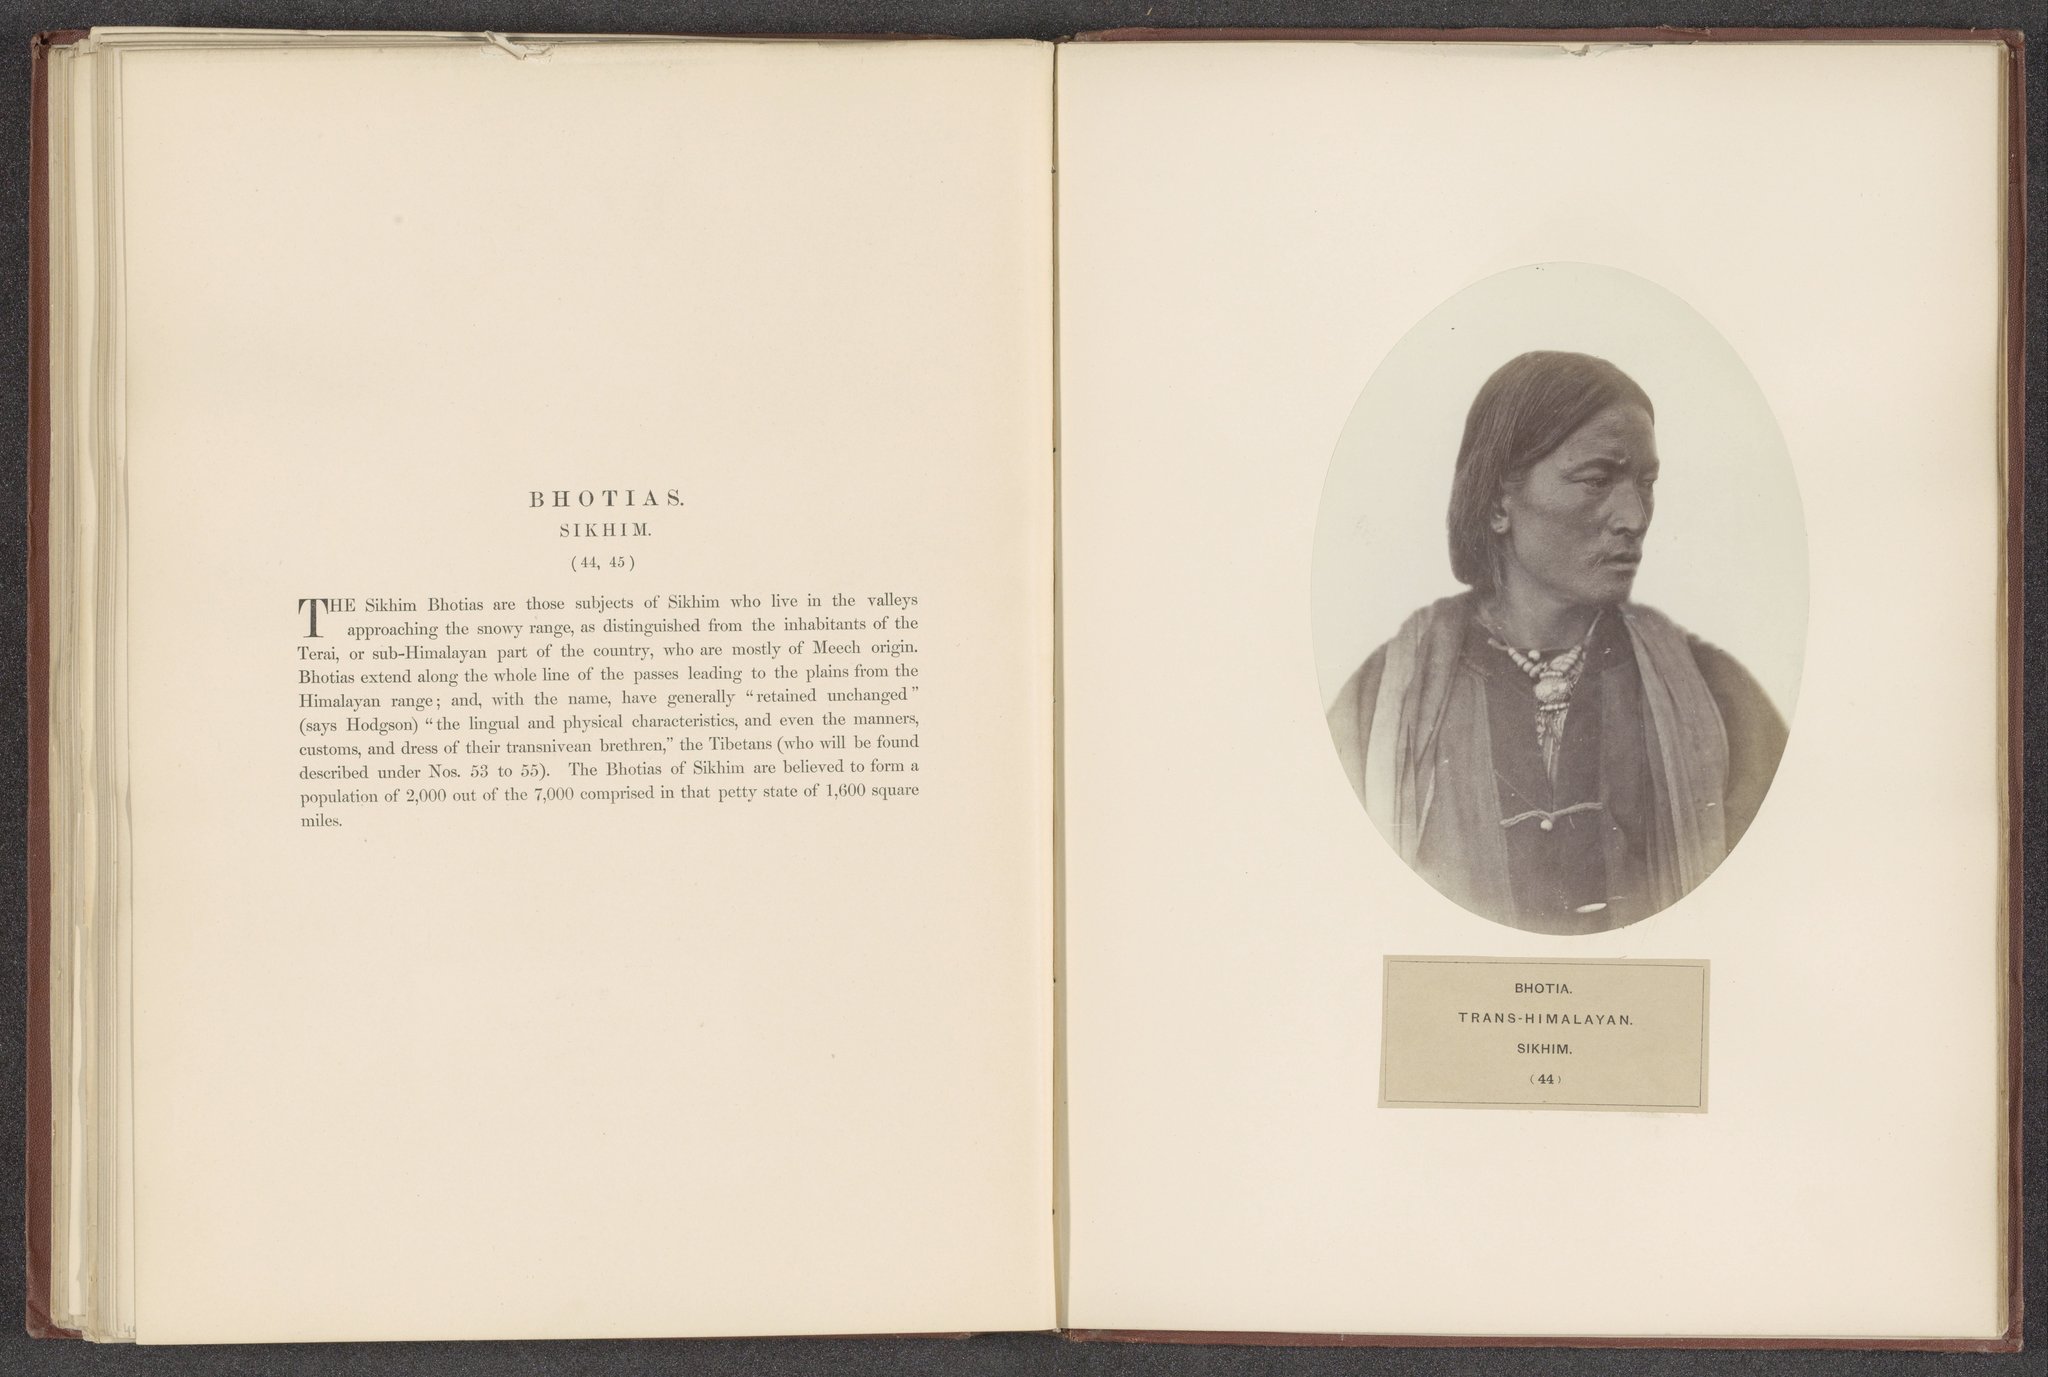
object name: page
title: Portrait of an unknown man from the Bhutia community of Sikkim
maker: benjamin simpson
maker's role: fotograaf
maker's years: 1831-1923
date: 1858-1868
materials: photographic support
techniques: albumen print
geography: sikkim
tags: human races; peoples; nationalities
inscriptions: inscription: ‘BHOTIA./ TRANS-HIMALAYAN./ SIKHIM.’, number: ‘(44)’